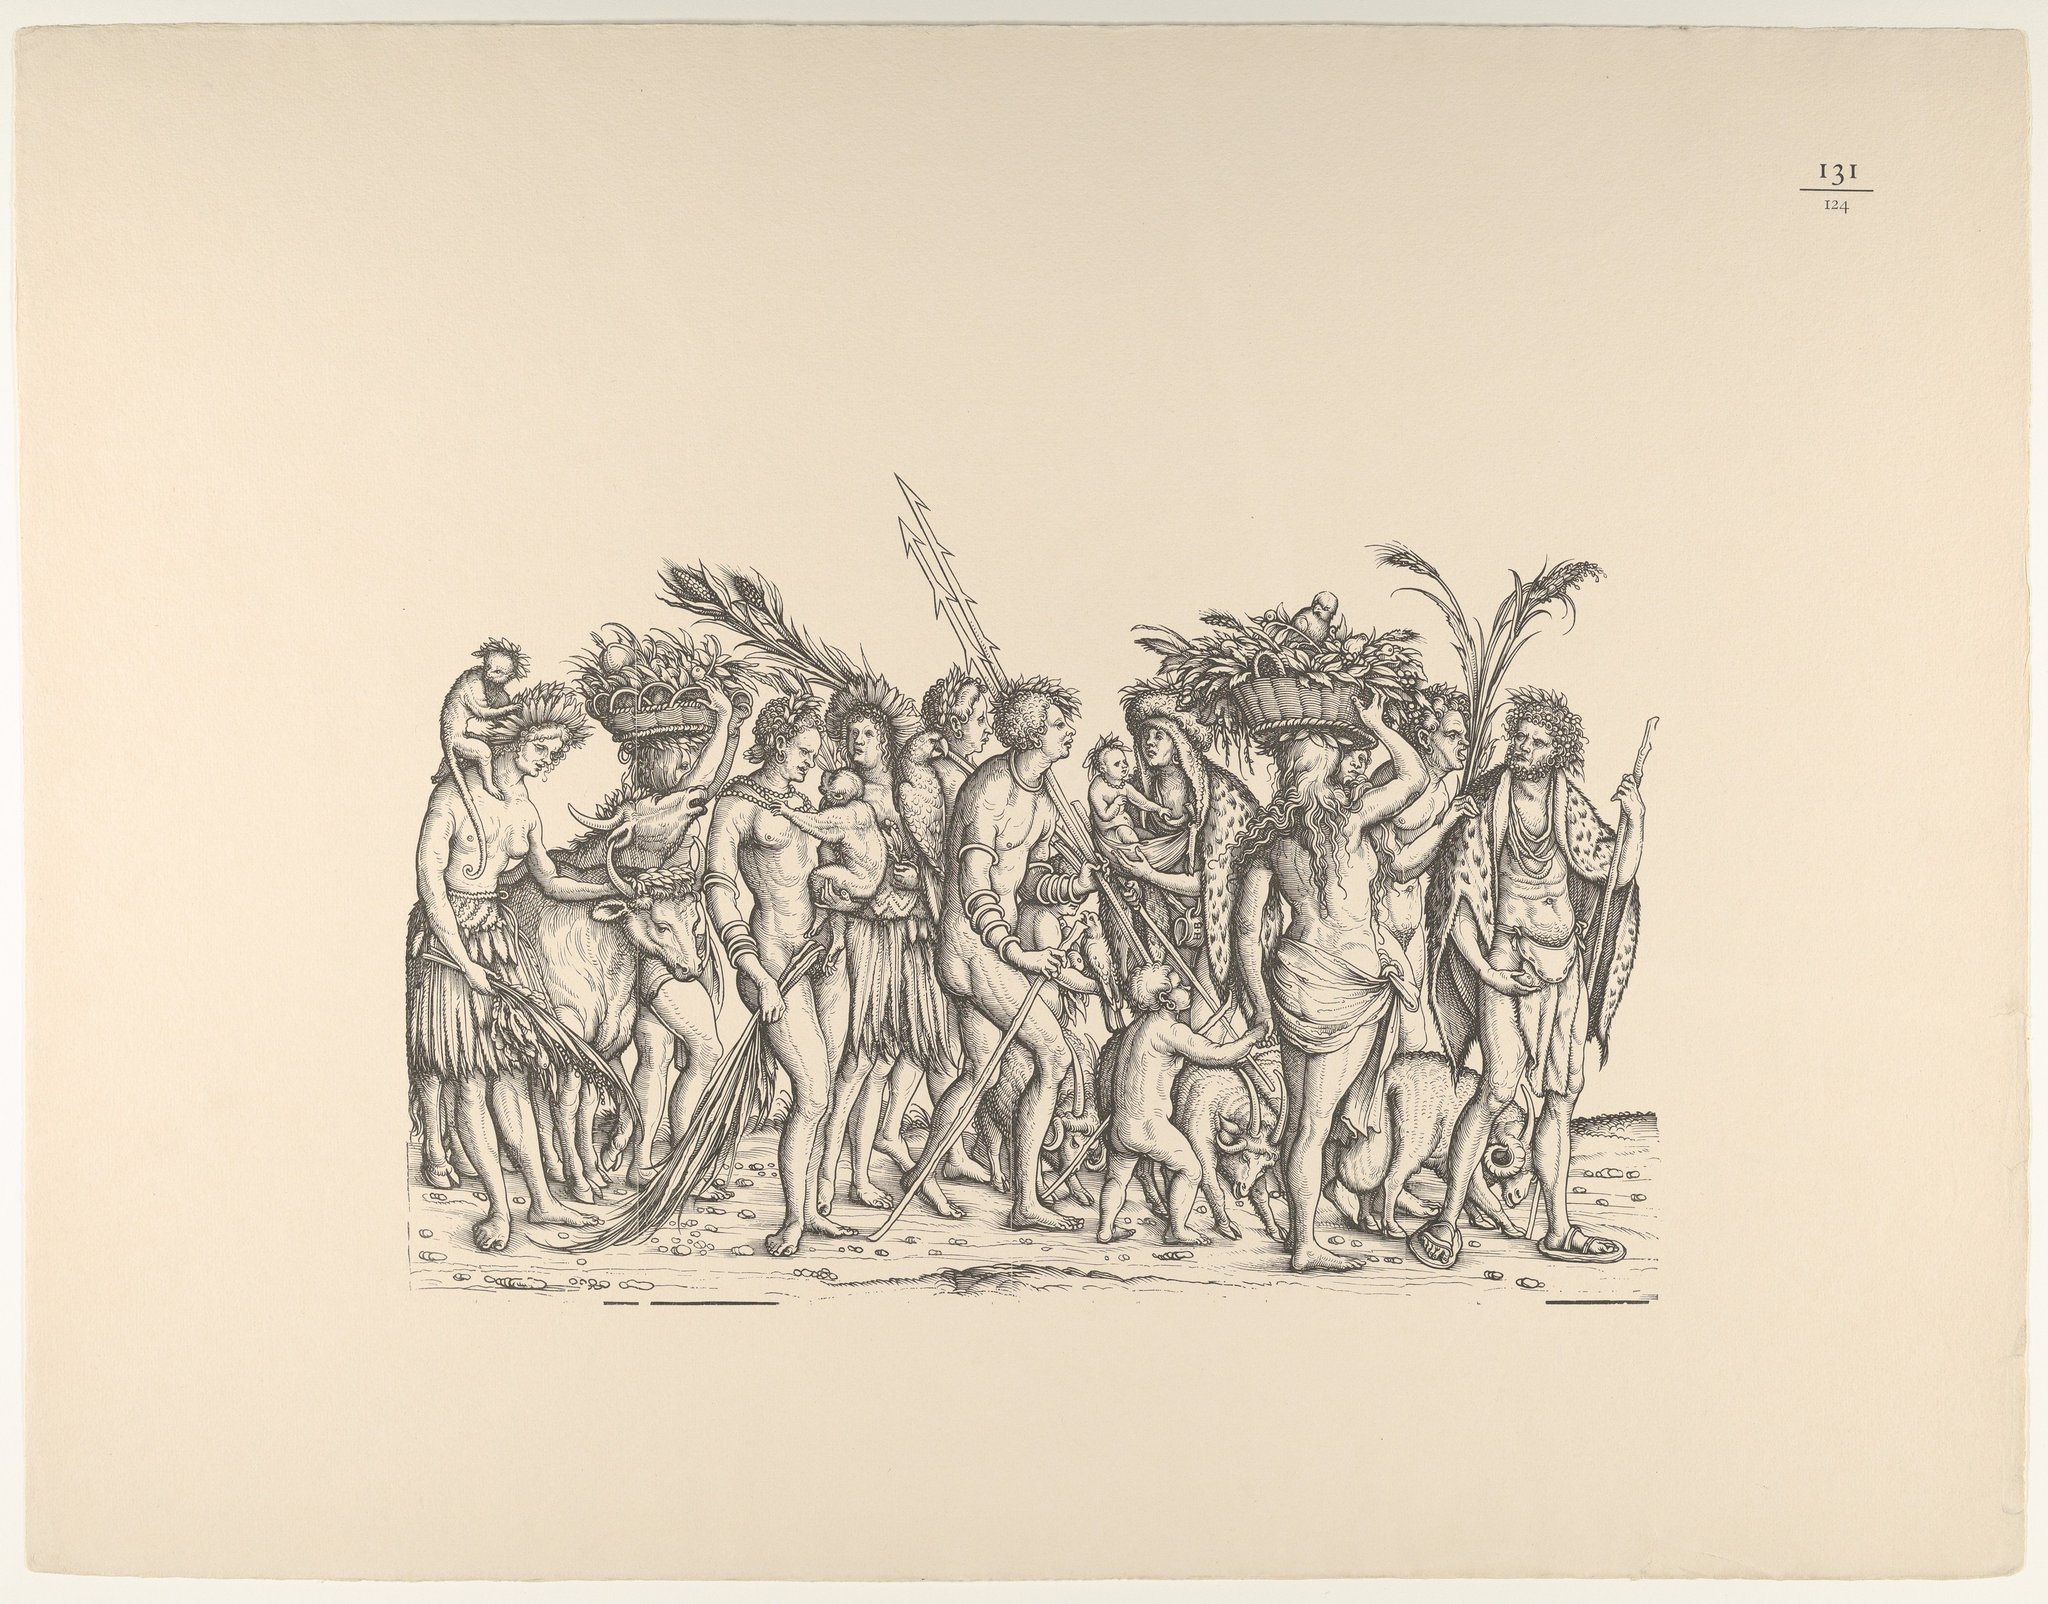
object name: print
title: People from Calicut, from The Triumphal Procession of Emperor Maximilian (Triumph Des Kaisers Maximilian I)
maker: hans burgkmair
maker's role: artist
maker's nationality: german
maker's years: 1473-1531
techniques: woodcut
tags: animals,children,male nudes,female nudes